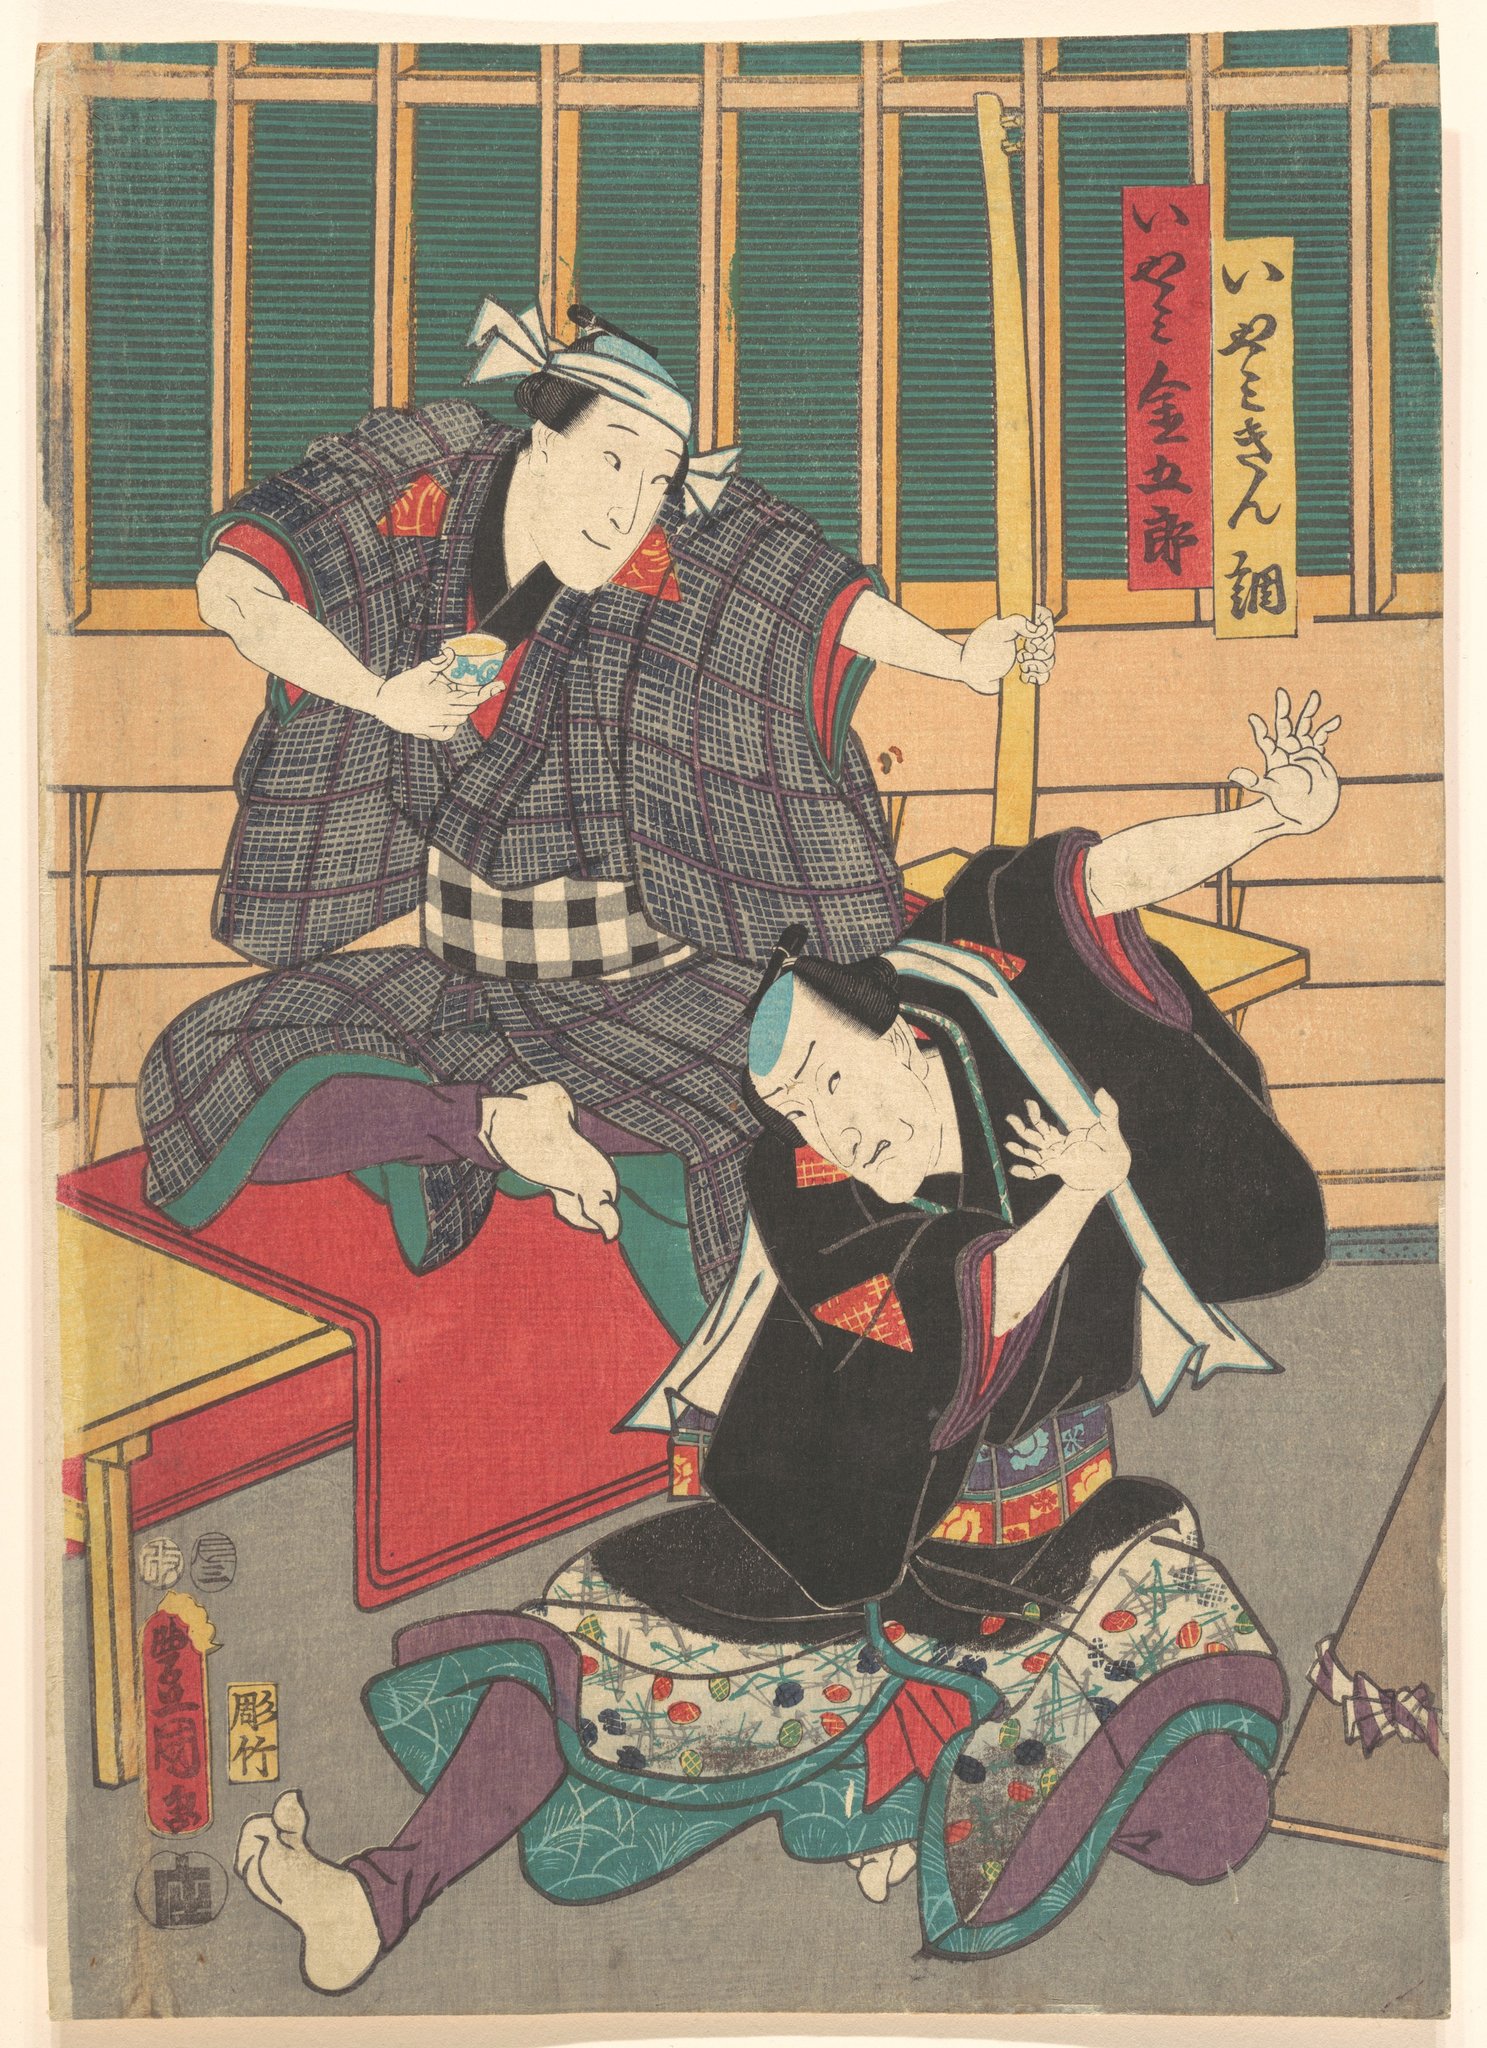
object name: print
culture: japanese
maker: utagawa kunisada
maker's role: artist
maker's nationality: japanese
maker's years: 1786-1864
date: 1786-1854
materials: ink, paper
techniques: woodblock print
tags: men